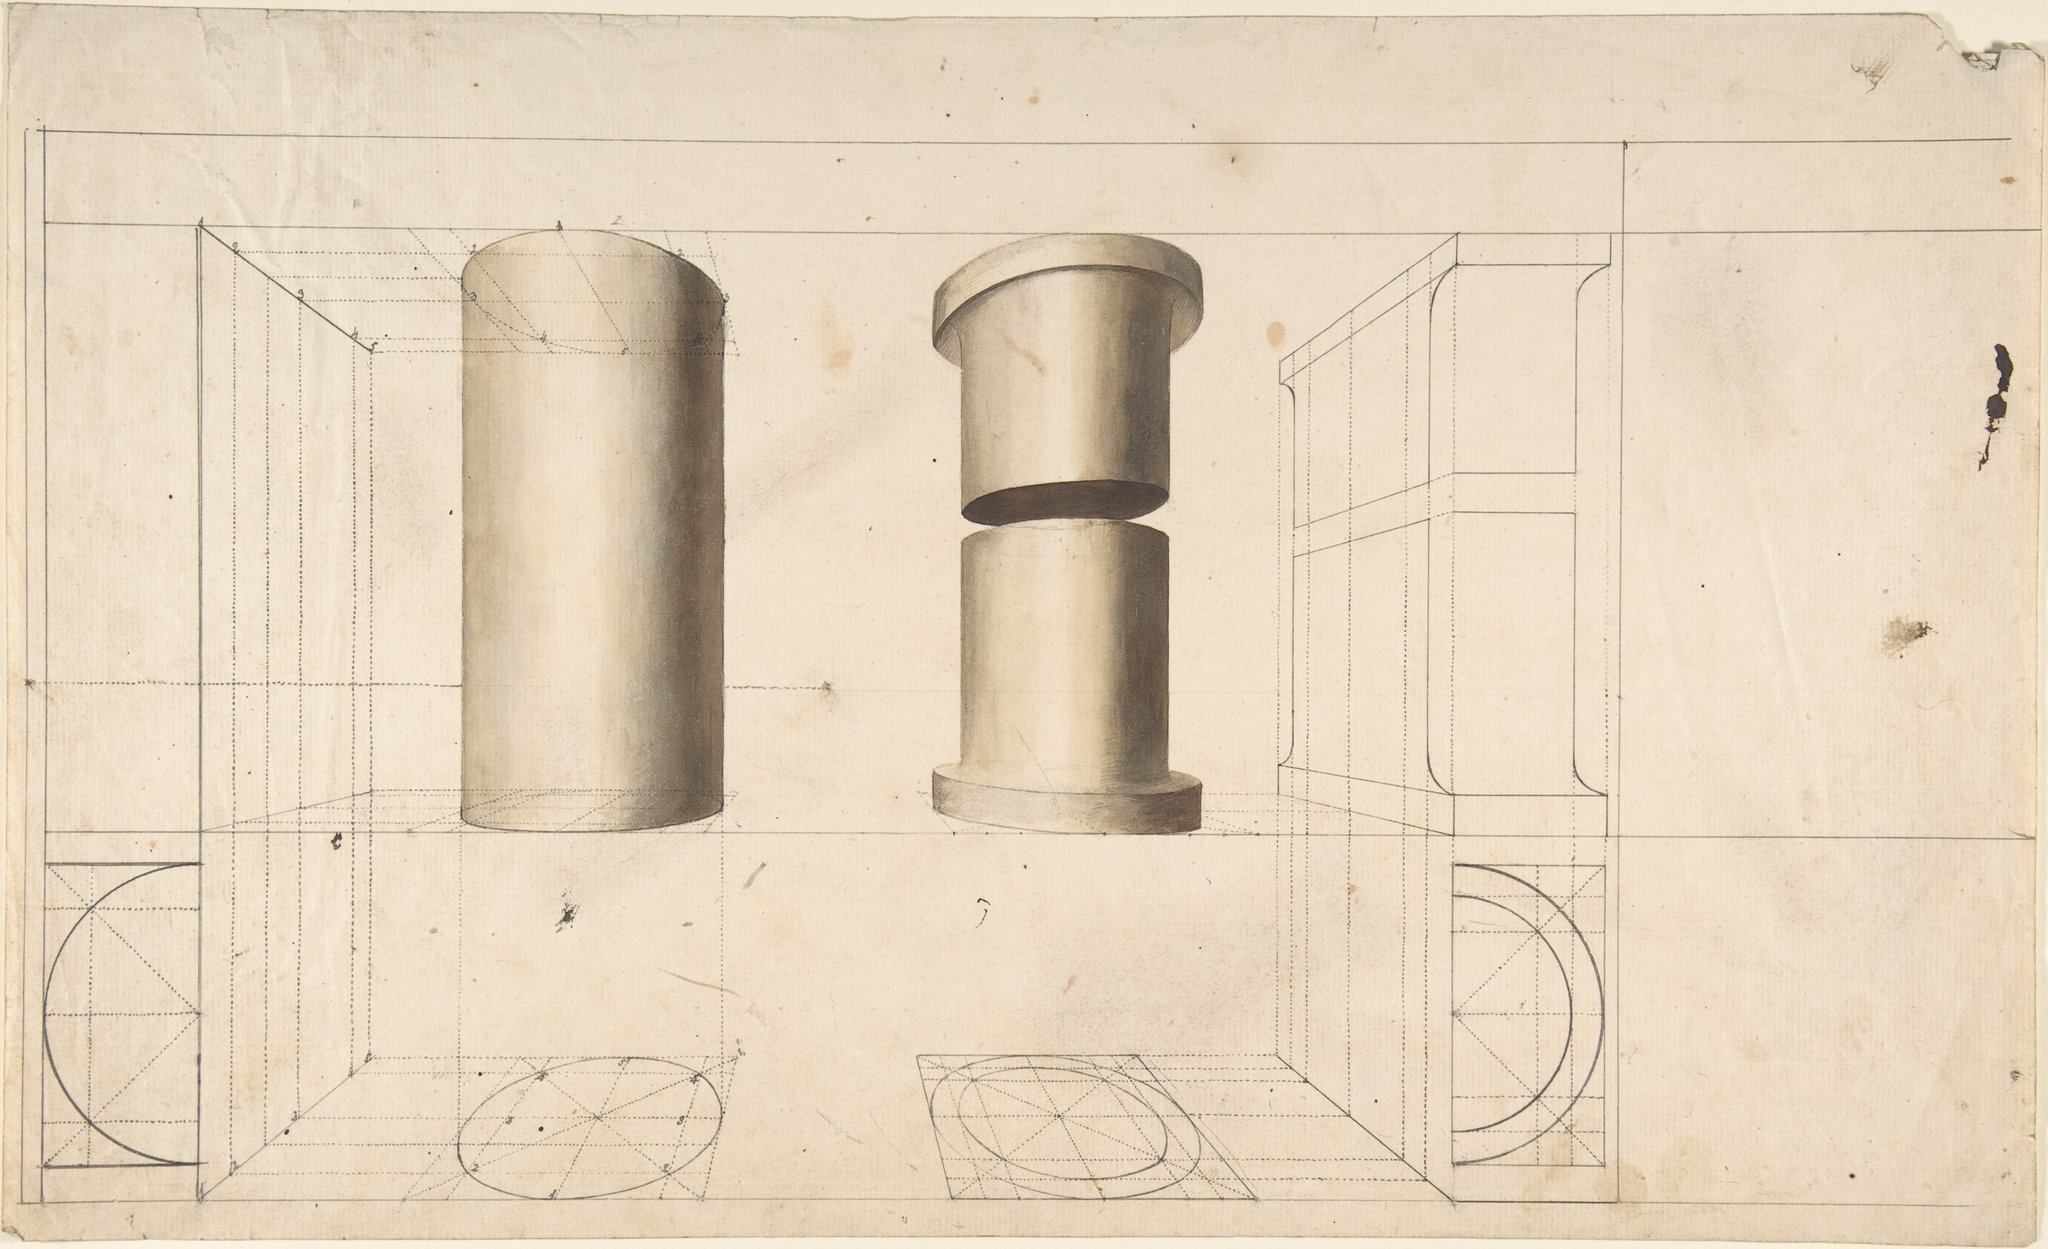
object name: drawing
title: Projections of Columns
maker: anonymous, british, 18th century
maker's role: artist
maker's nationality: british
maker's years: 1700-1800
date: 1701-1800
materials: ink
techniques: brush, pen, wash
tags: architecture